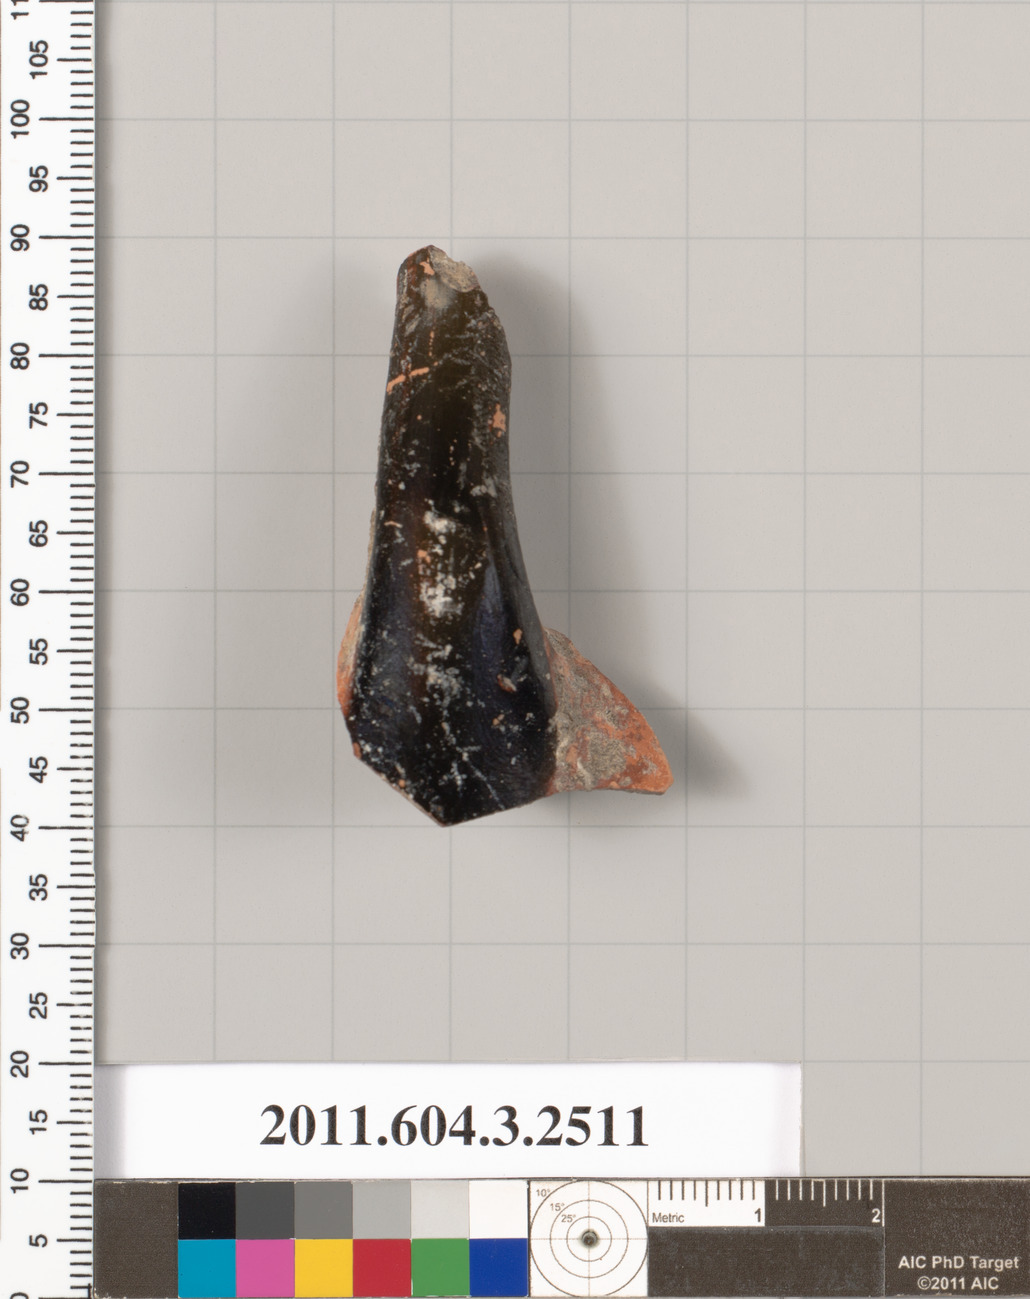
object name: kylix fragment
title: Terracotta fragment of a kylix (drinking cup)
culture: greek, attic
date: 600-401 BCE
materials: terracotta